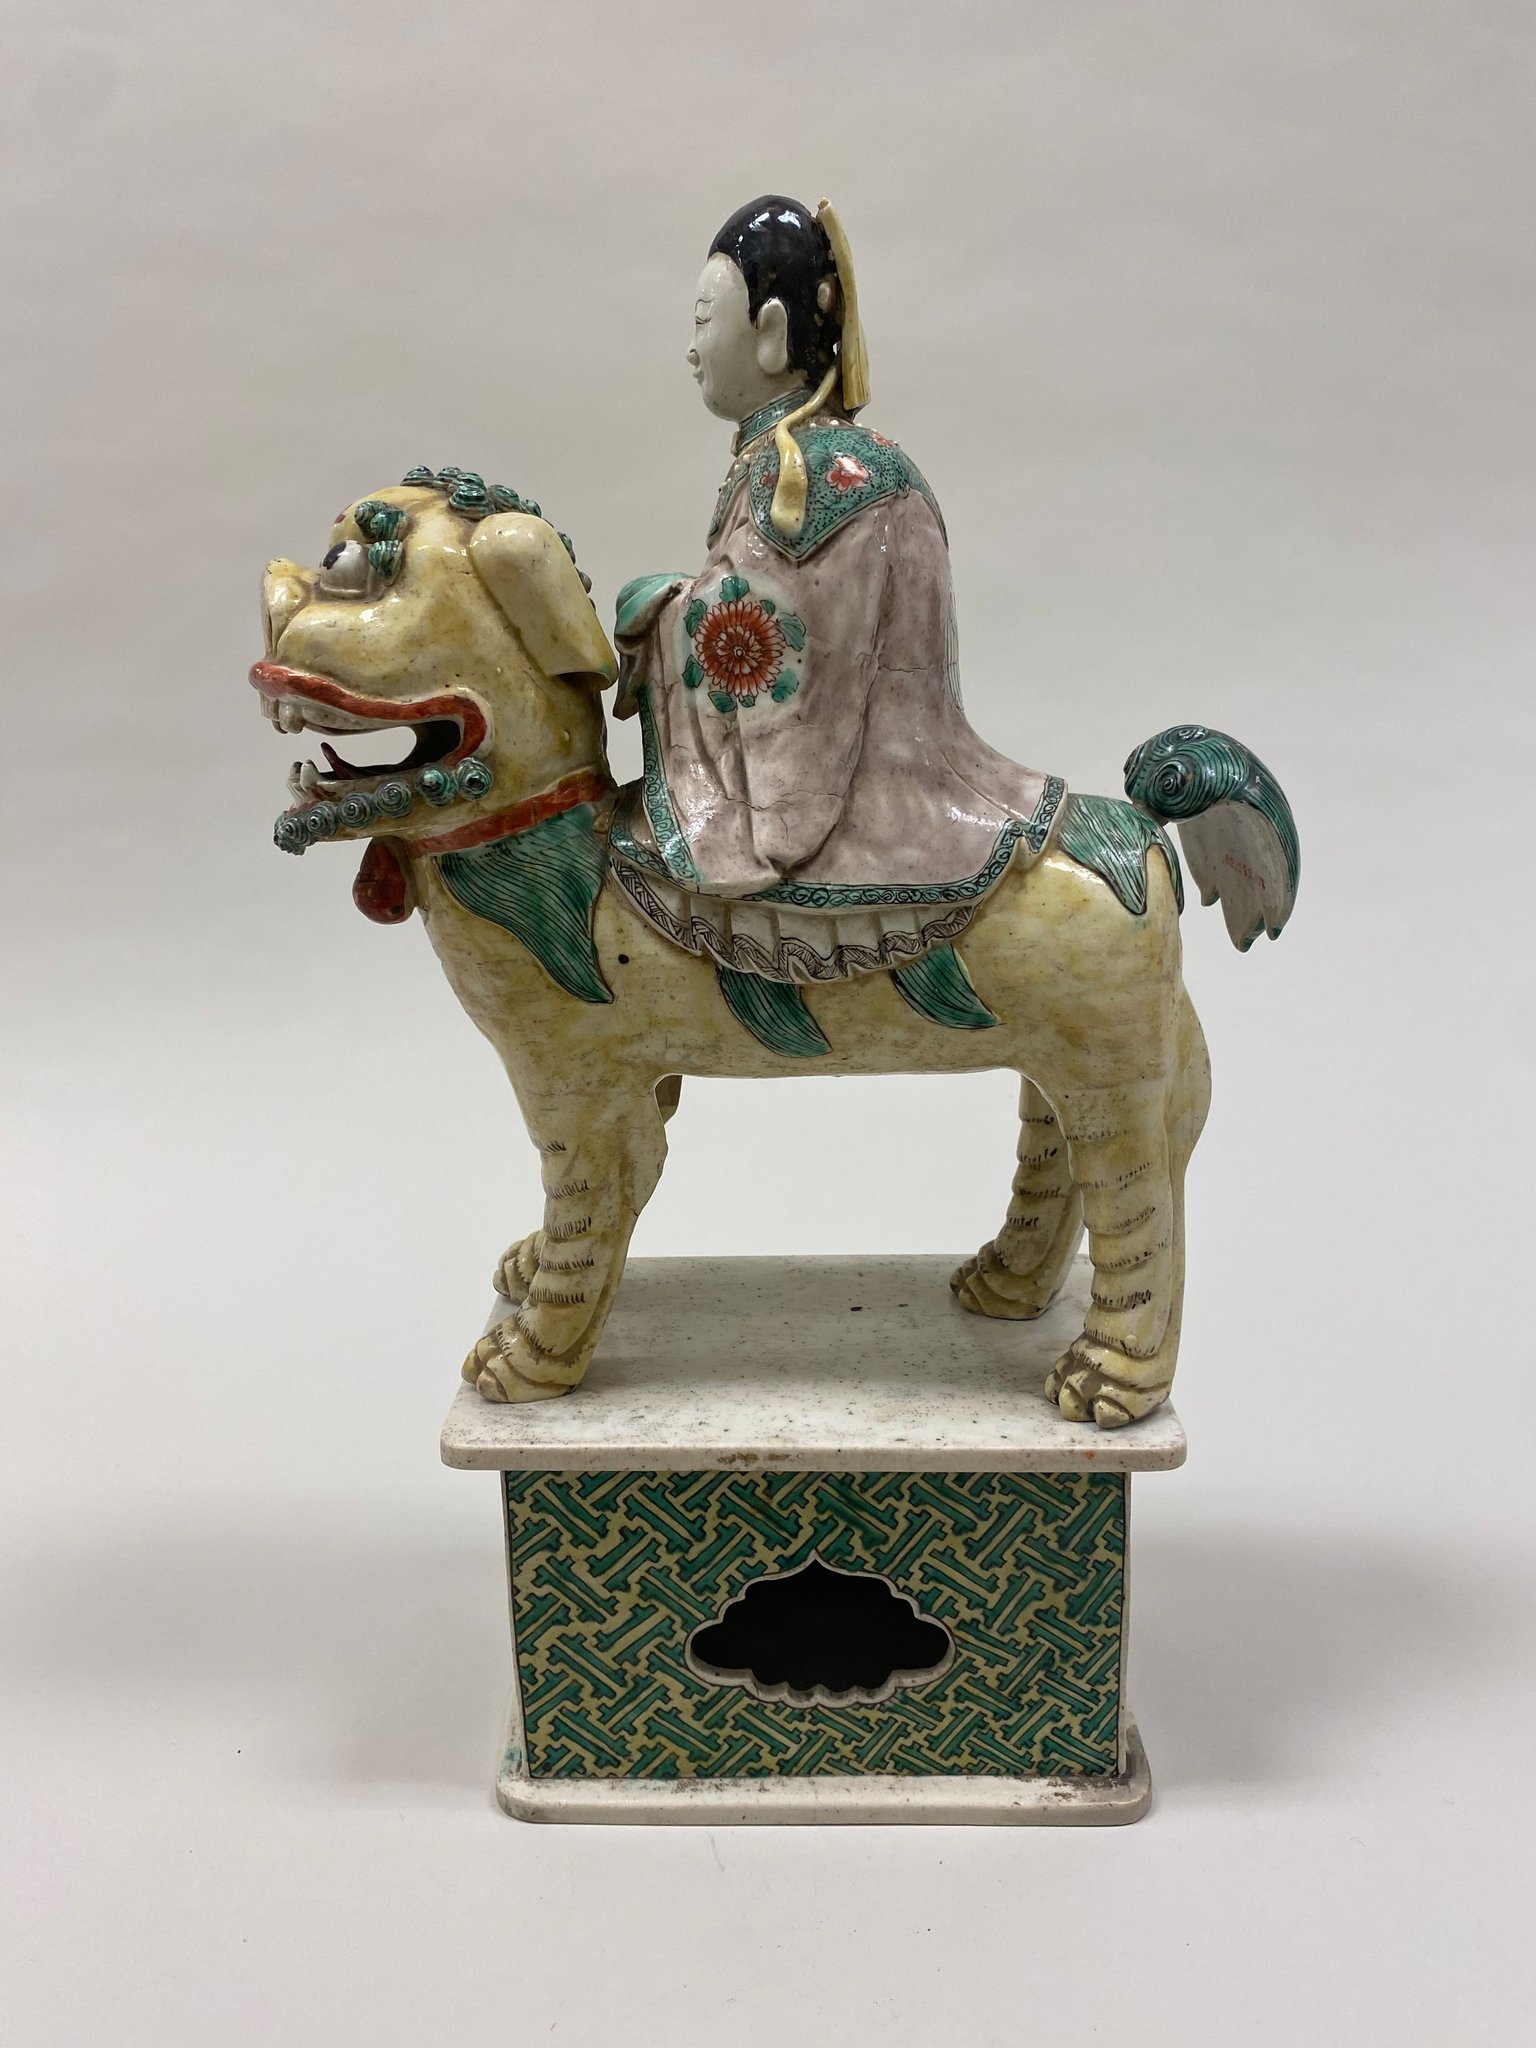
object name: figure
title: Figure of Bodhisattva Guanyin riding a lion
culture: chinese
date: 1701-1733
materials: biscuit, enamel, porcelain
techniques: painting, polychrome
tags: lions,bodhisattvas